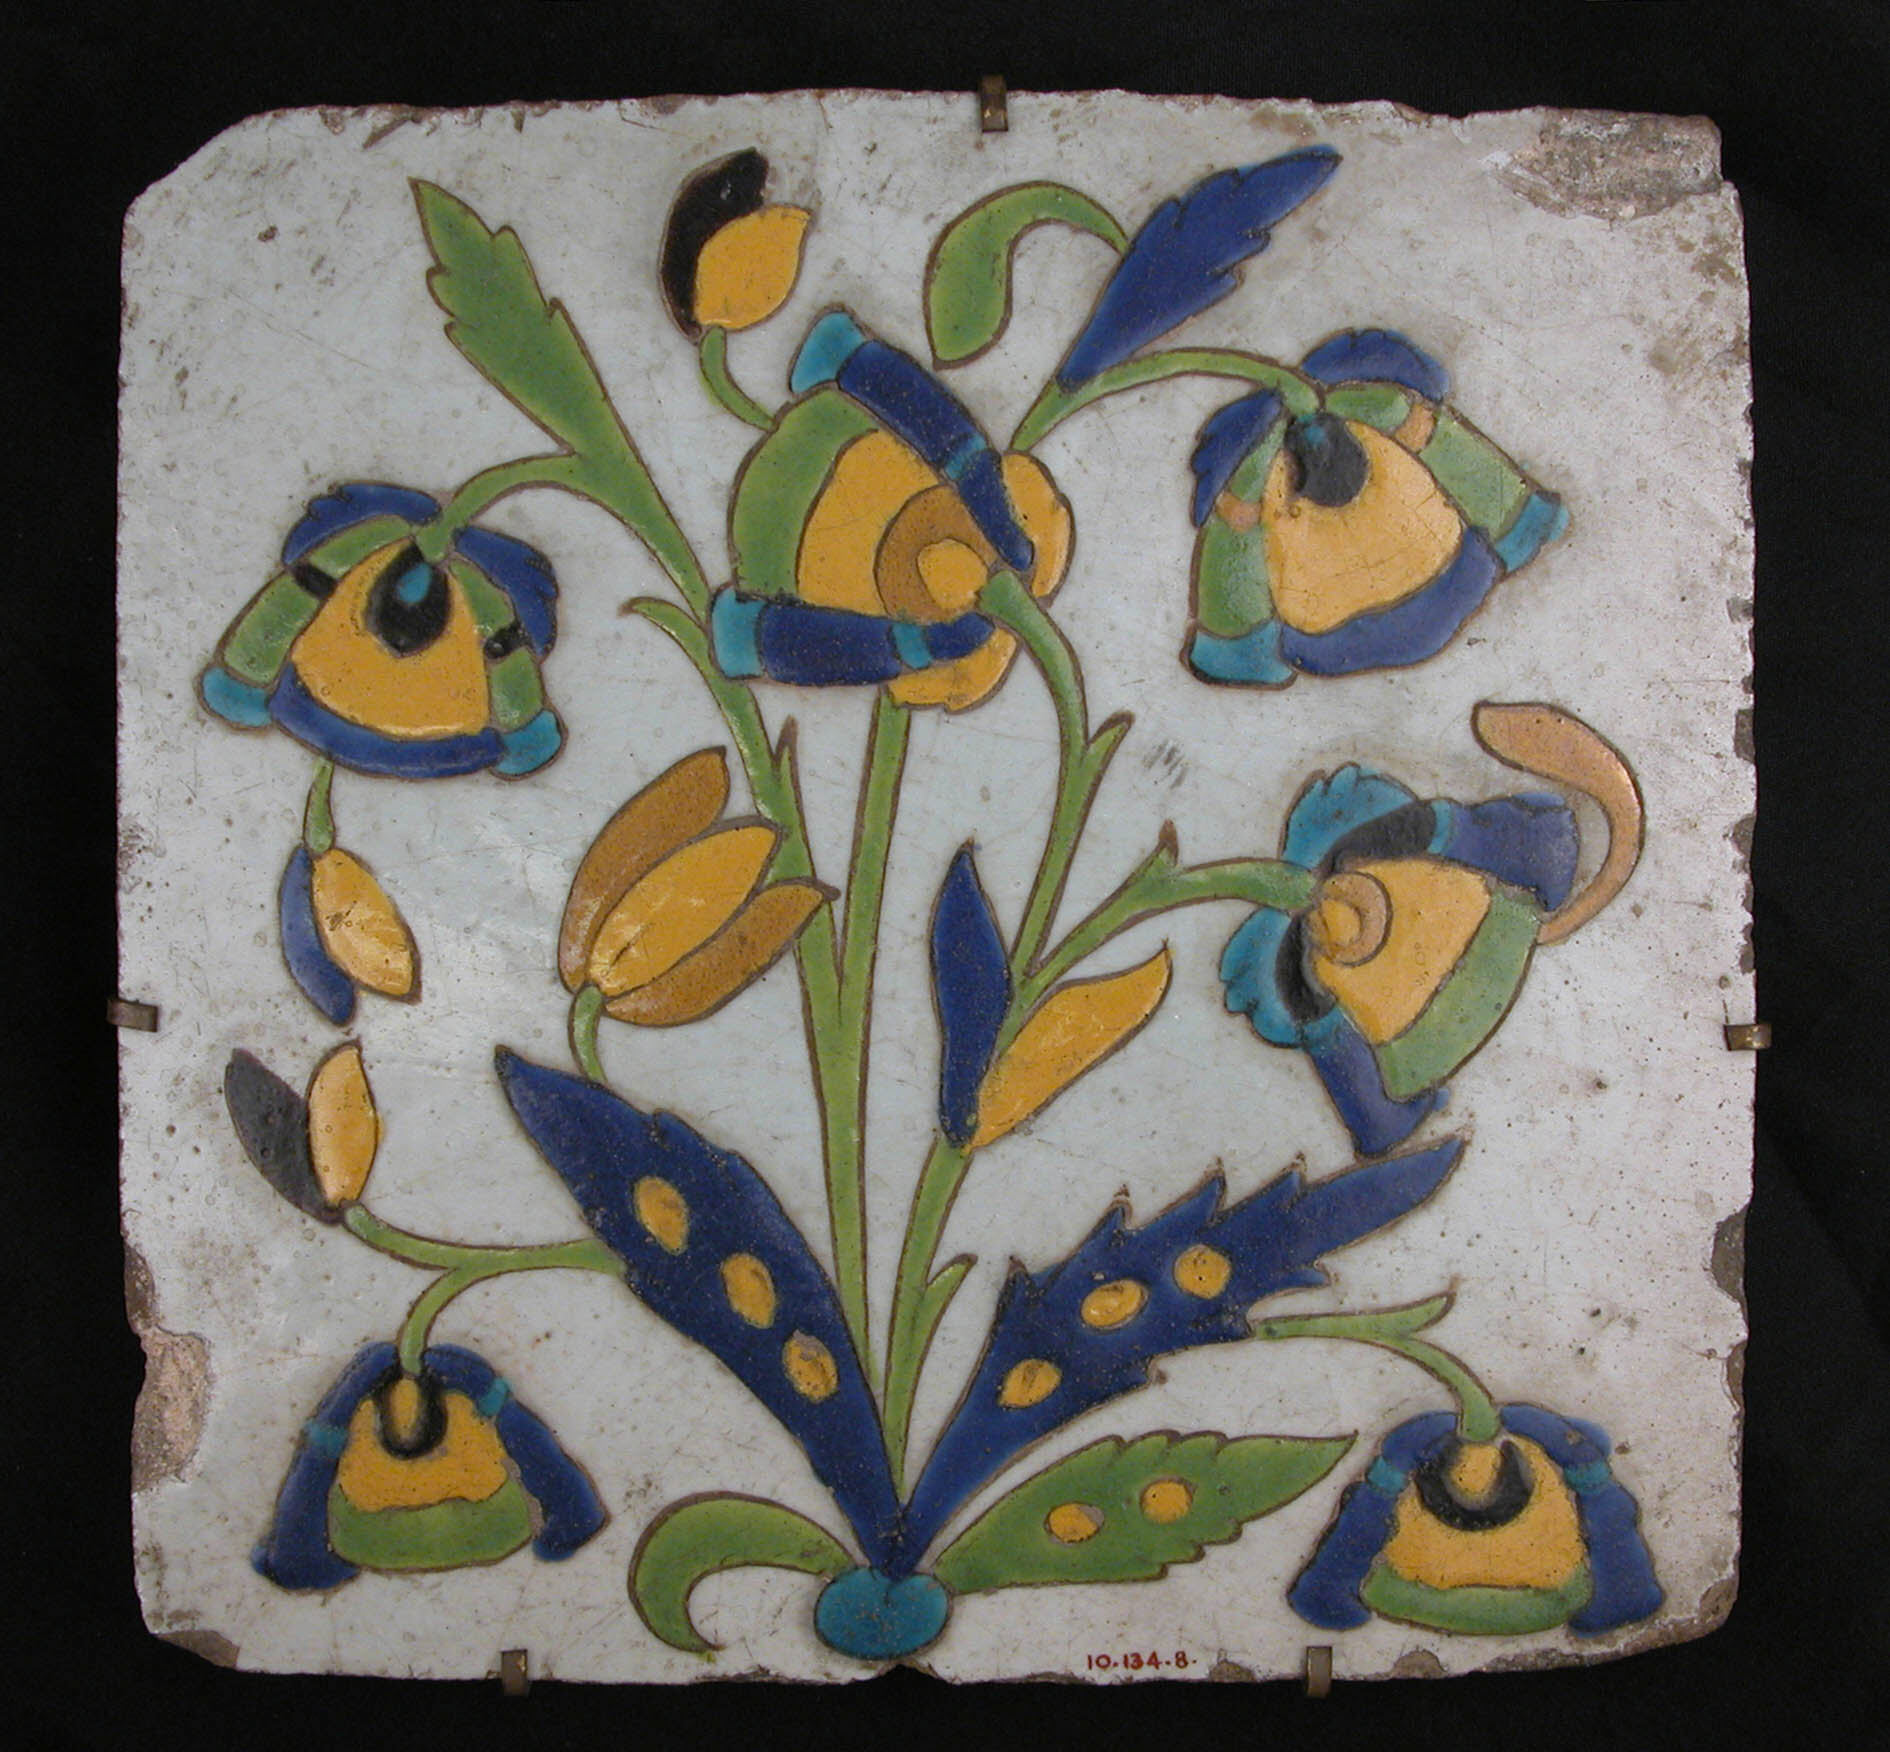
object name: tile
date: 1701-1800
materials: stonepaste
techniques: glazing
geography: iran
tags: flowers,leaves